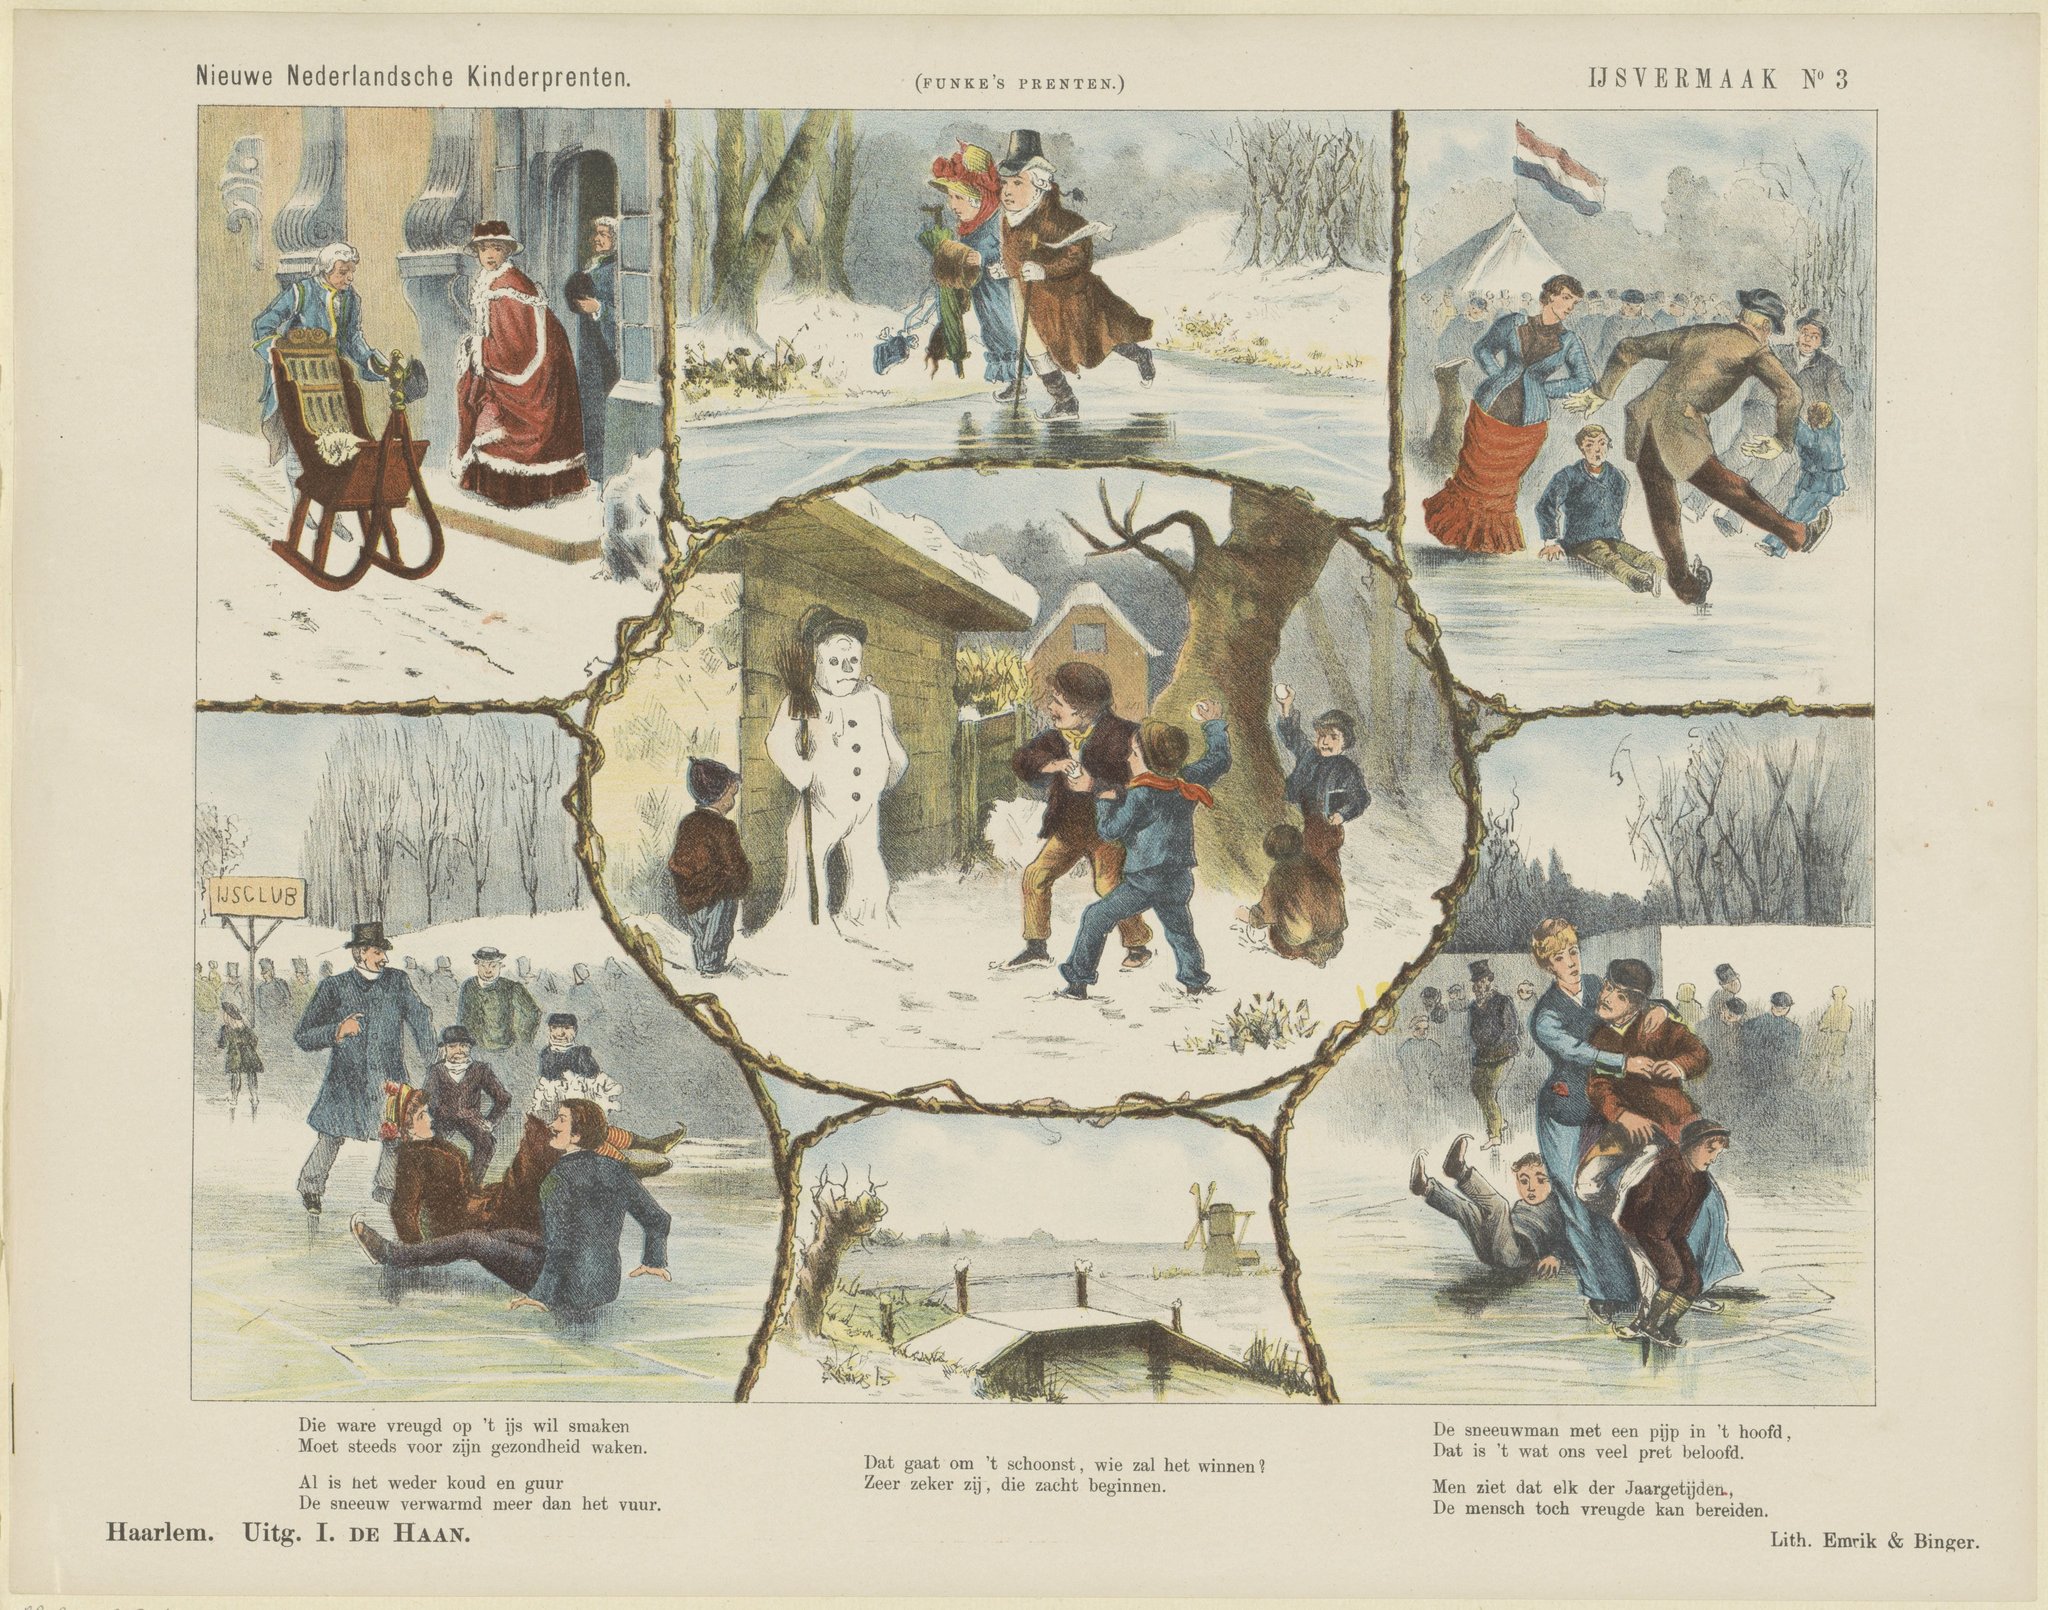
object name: print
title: Ijsvermaak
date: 1875-1903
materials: paper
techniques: lithograph, letterpress printing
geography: haarlem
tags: (making a) snowman, skates (winter sports)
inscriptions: collector's mark: Lugt 2760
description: Blad met 7 voorstellingen van winteractiviteiten, waaronder schaatsen, sleetje rijden en een sneeuwpop maken. In de ondermarge een vers. Genummerd rechtsboven: No 3.